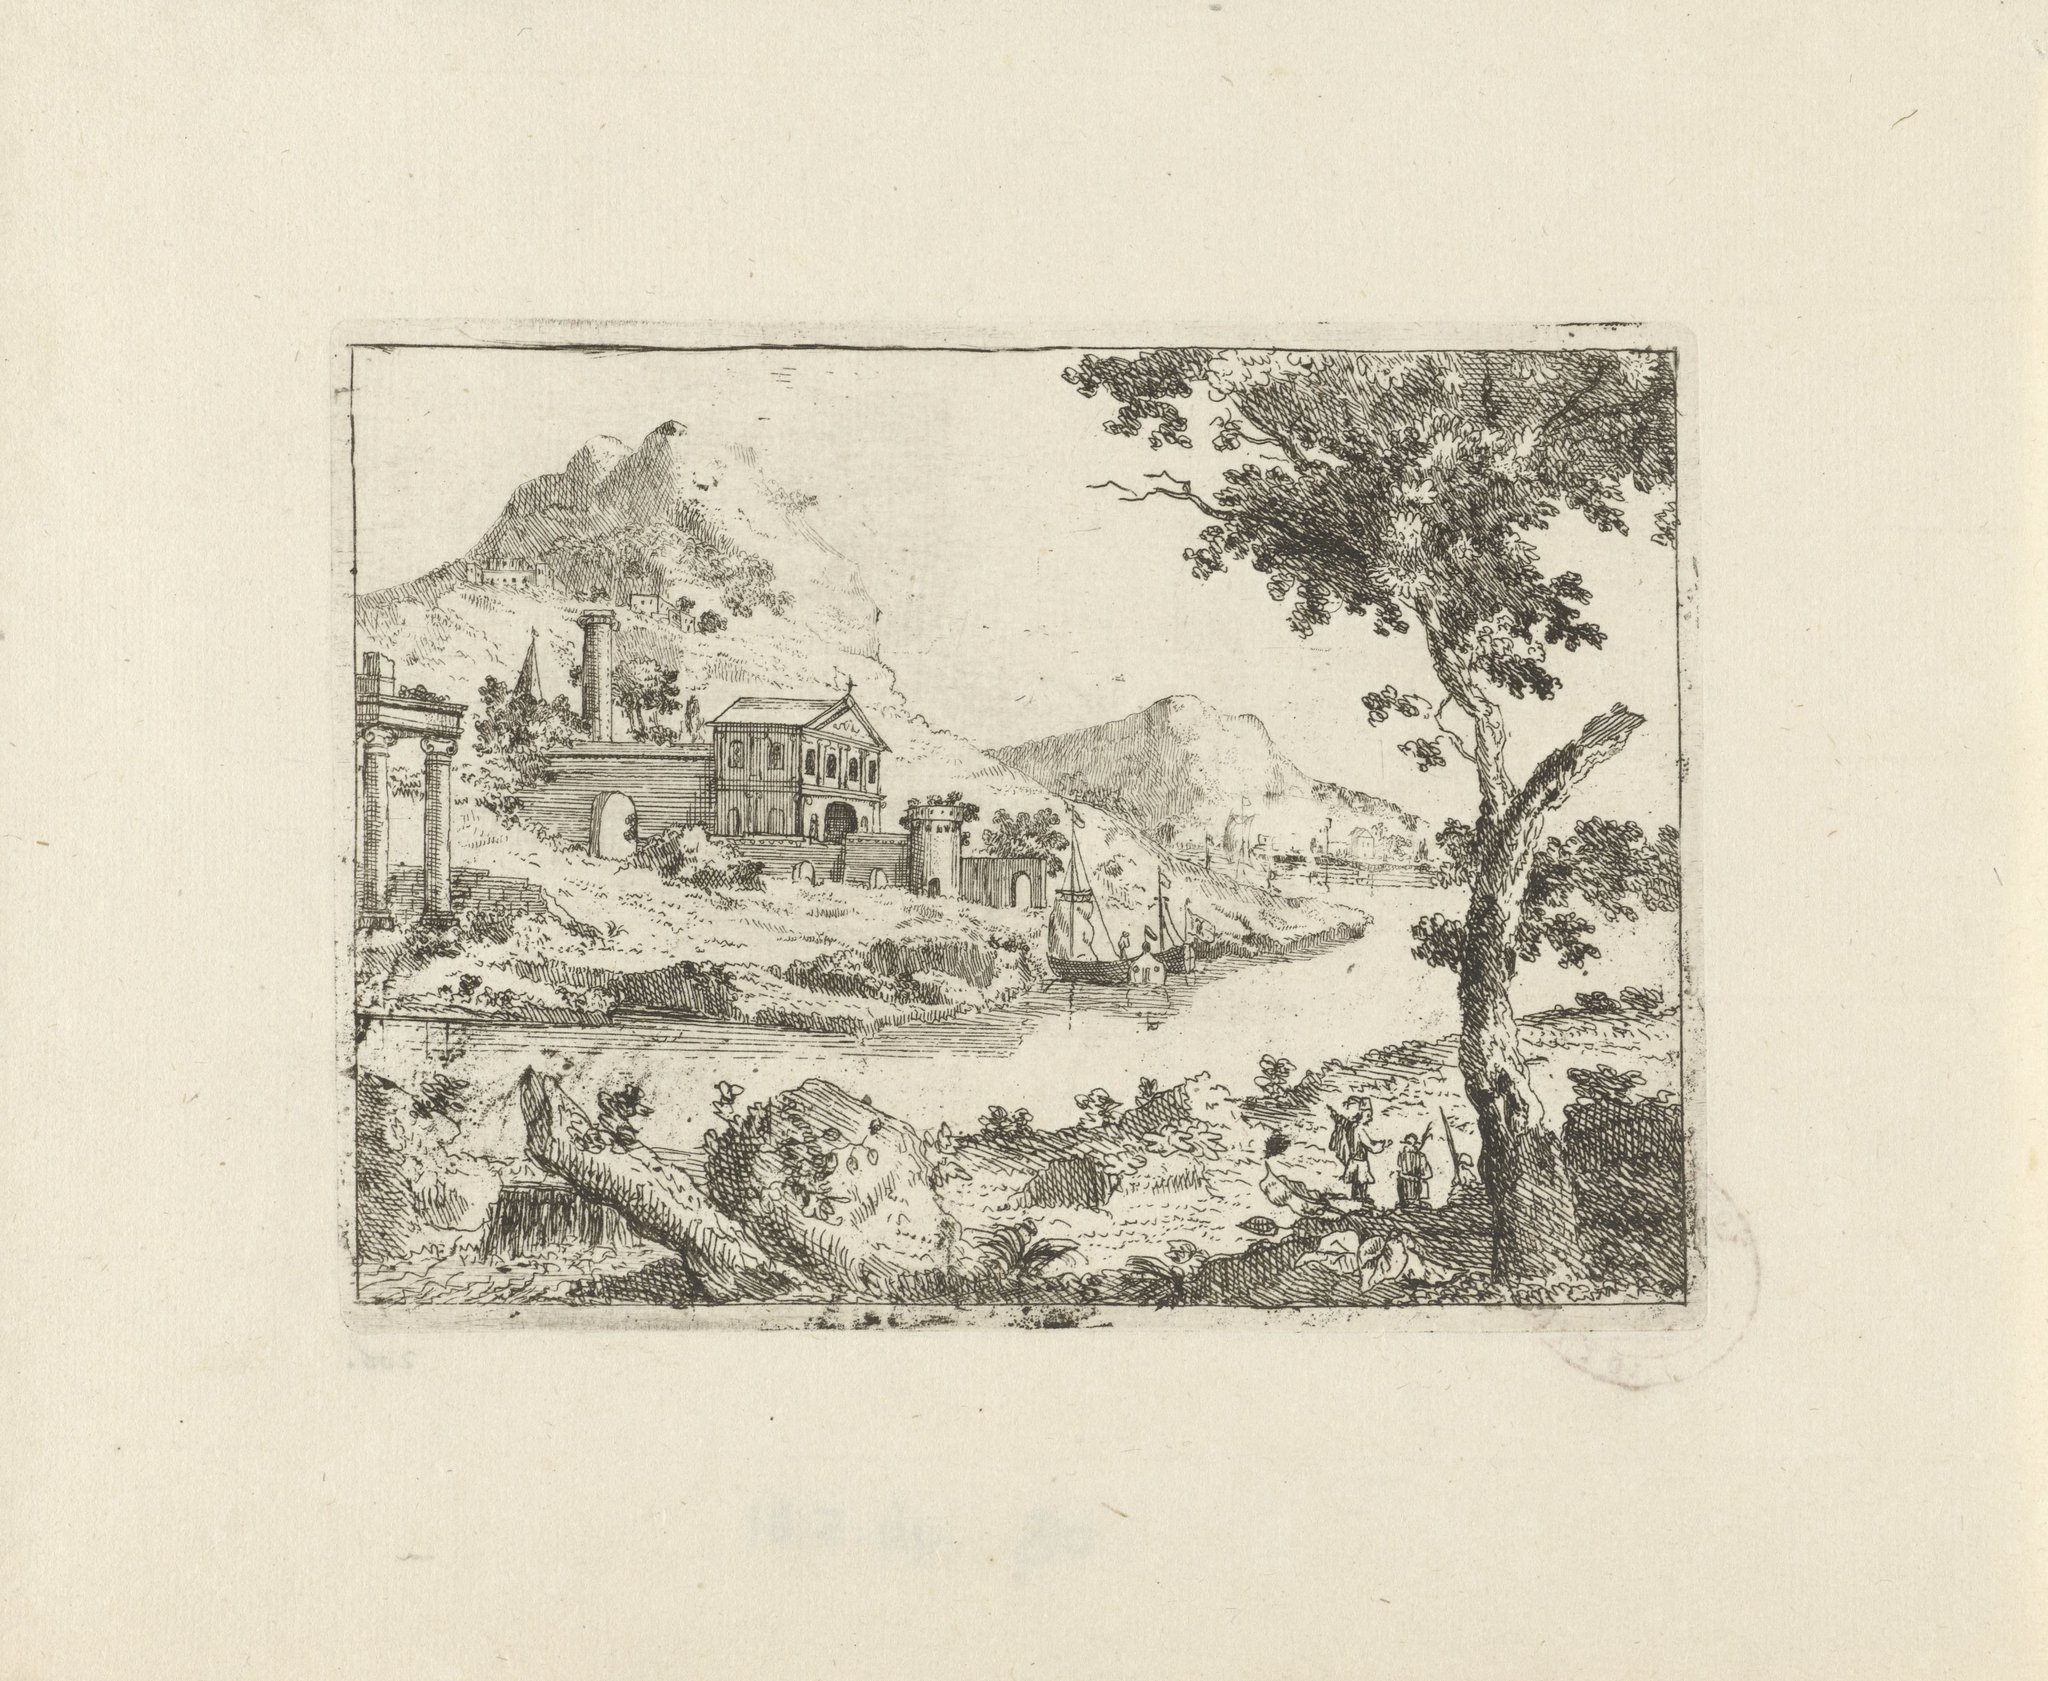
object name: print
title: Rivierlandschap met kerk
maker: pieter langendijk (i)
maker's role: print maker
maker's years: 1683-1756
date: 1693-1756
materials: paper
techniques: etching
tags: landscape with ruins - ii - ideal landscapes (+ variant), church (exterior)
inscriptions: collector's mark: Lugt 240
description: Rivierlandschap met op de oever een kerk en enkele restanten van antieke bouwwerken.